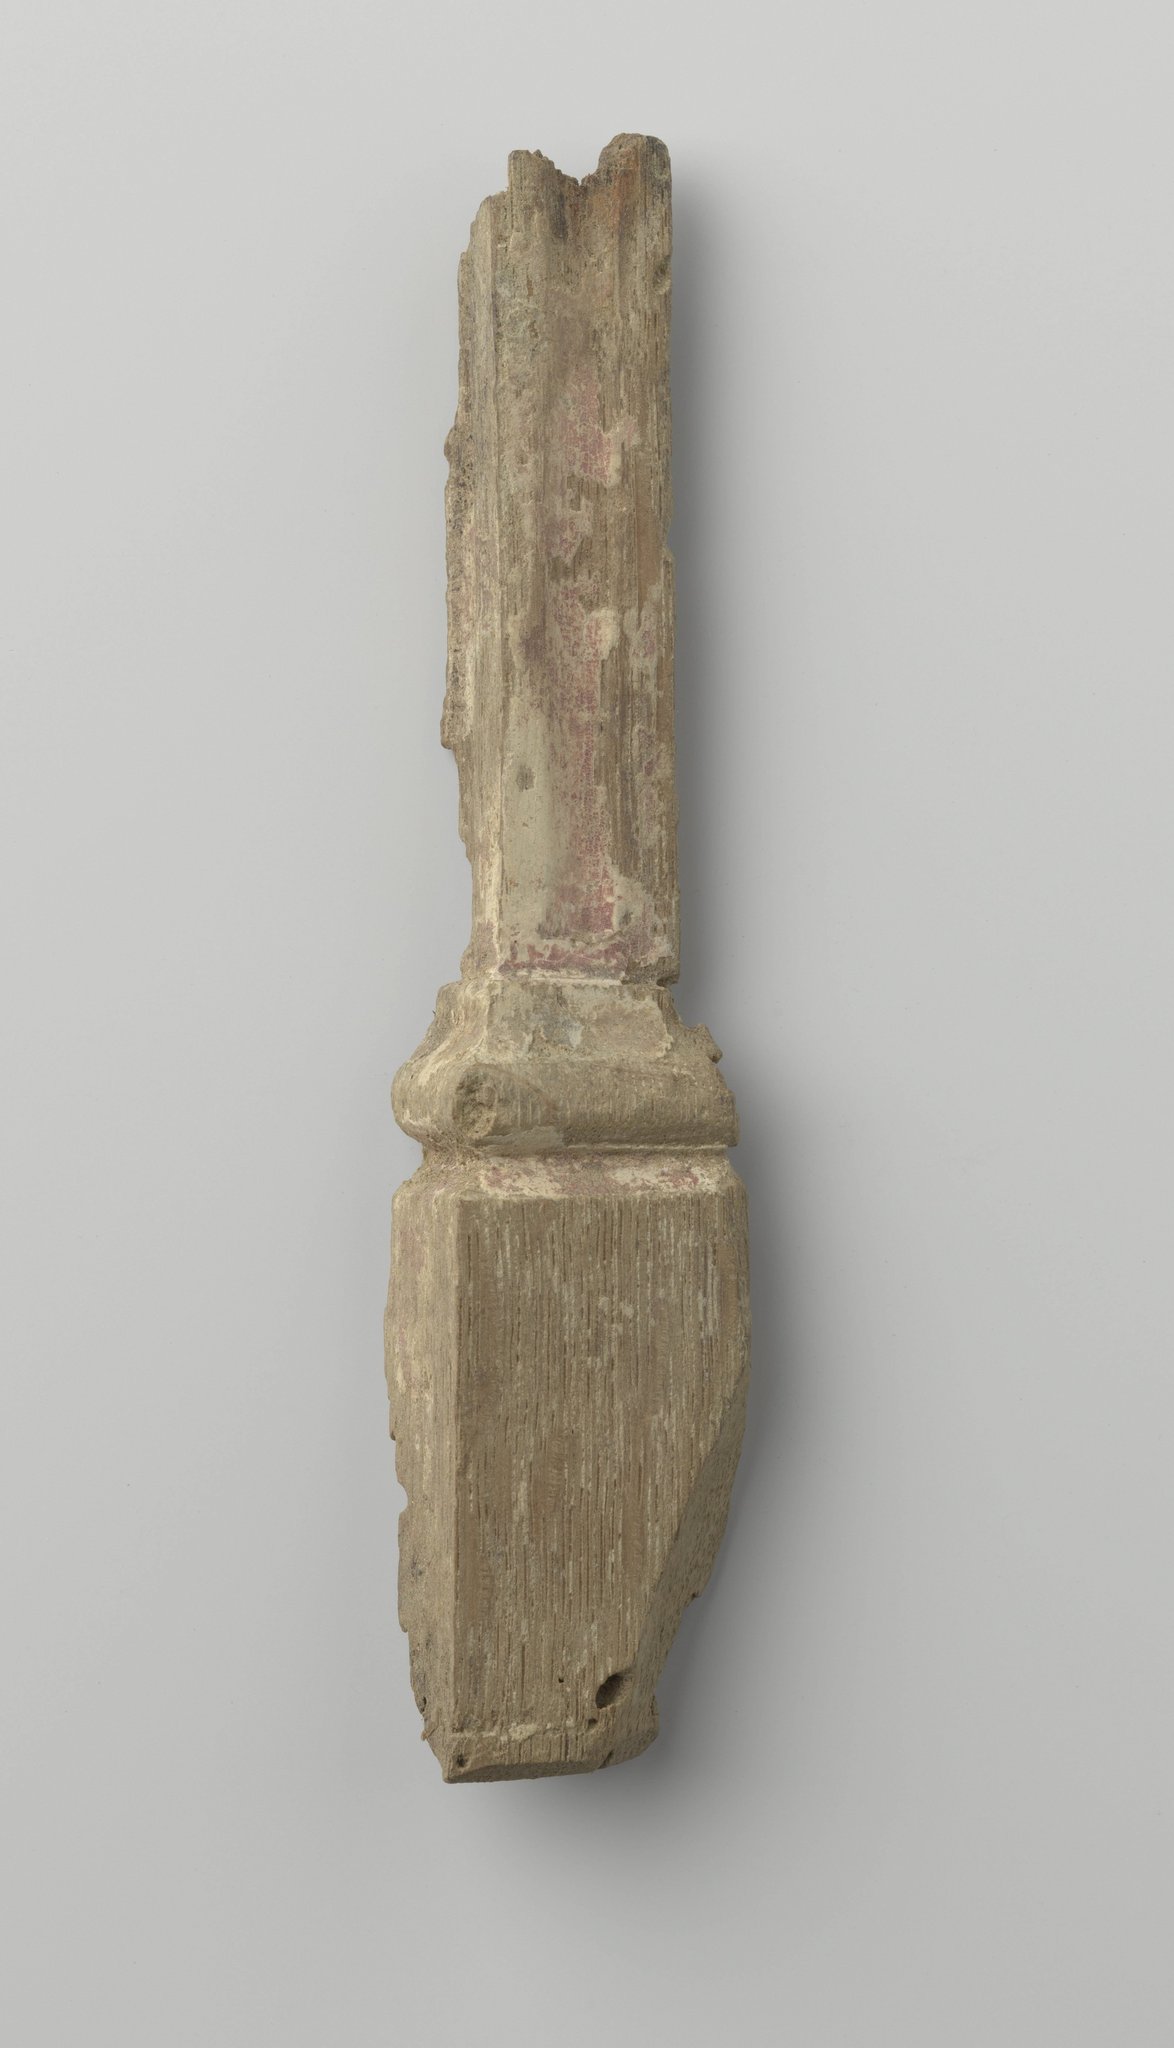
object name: fragment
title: Fragment (van de altaarkast?); (mogelijk) behorend tot het retabel van Soest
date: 1475-1499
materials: wood